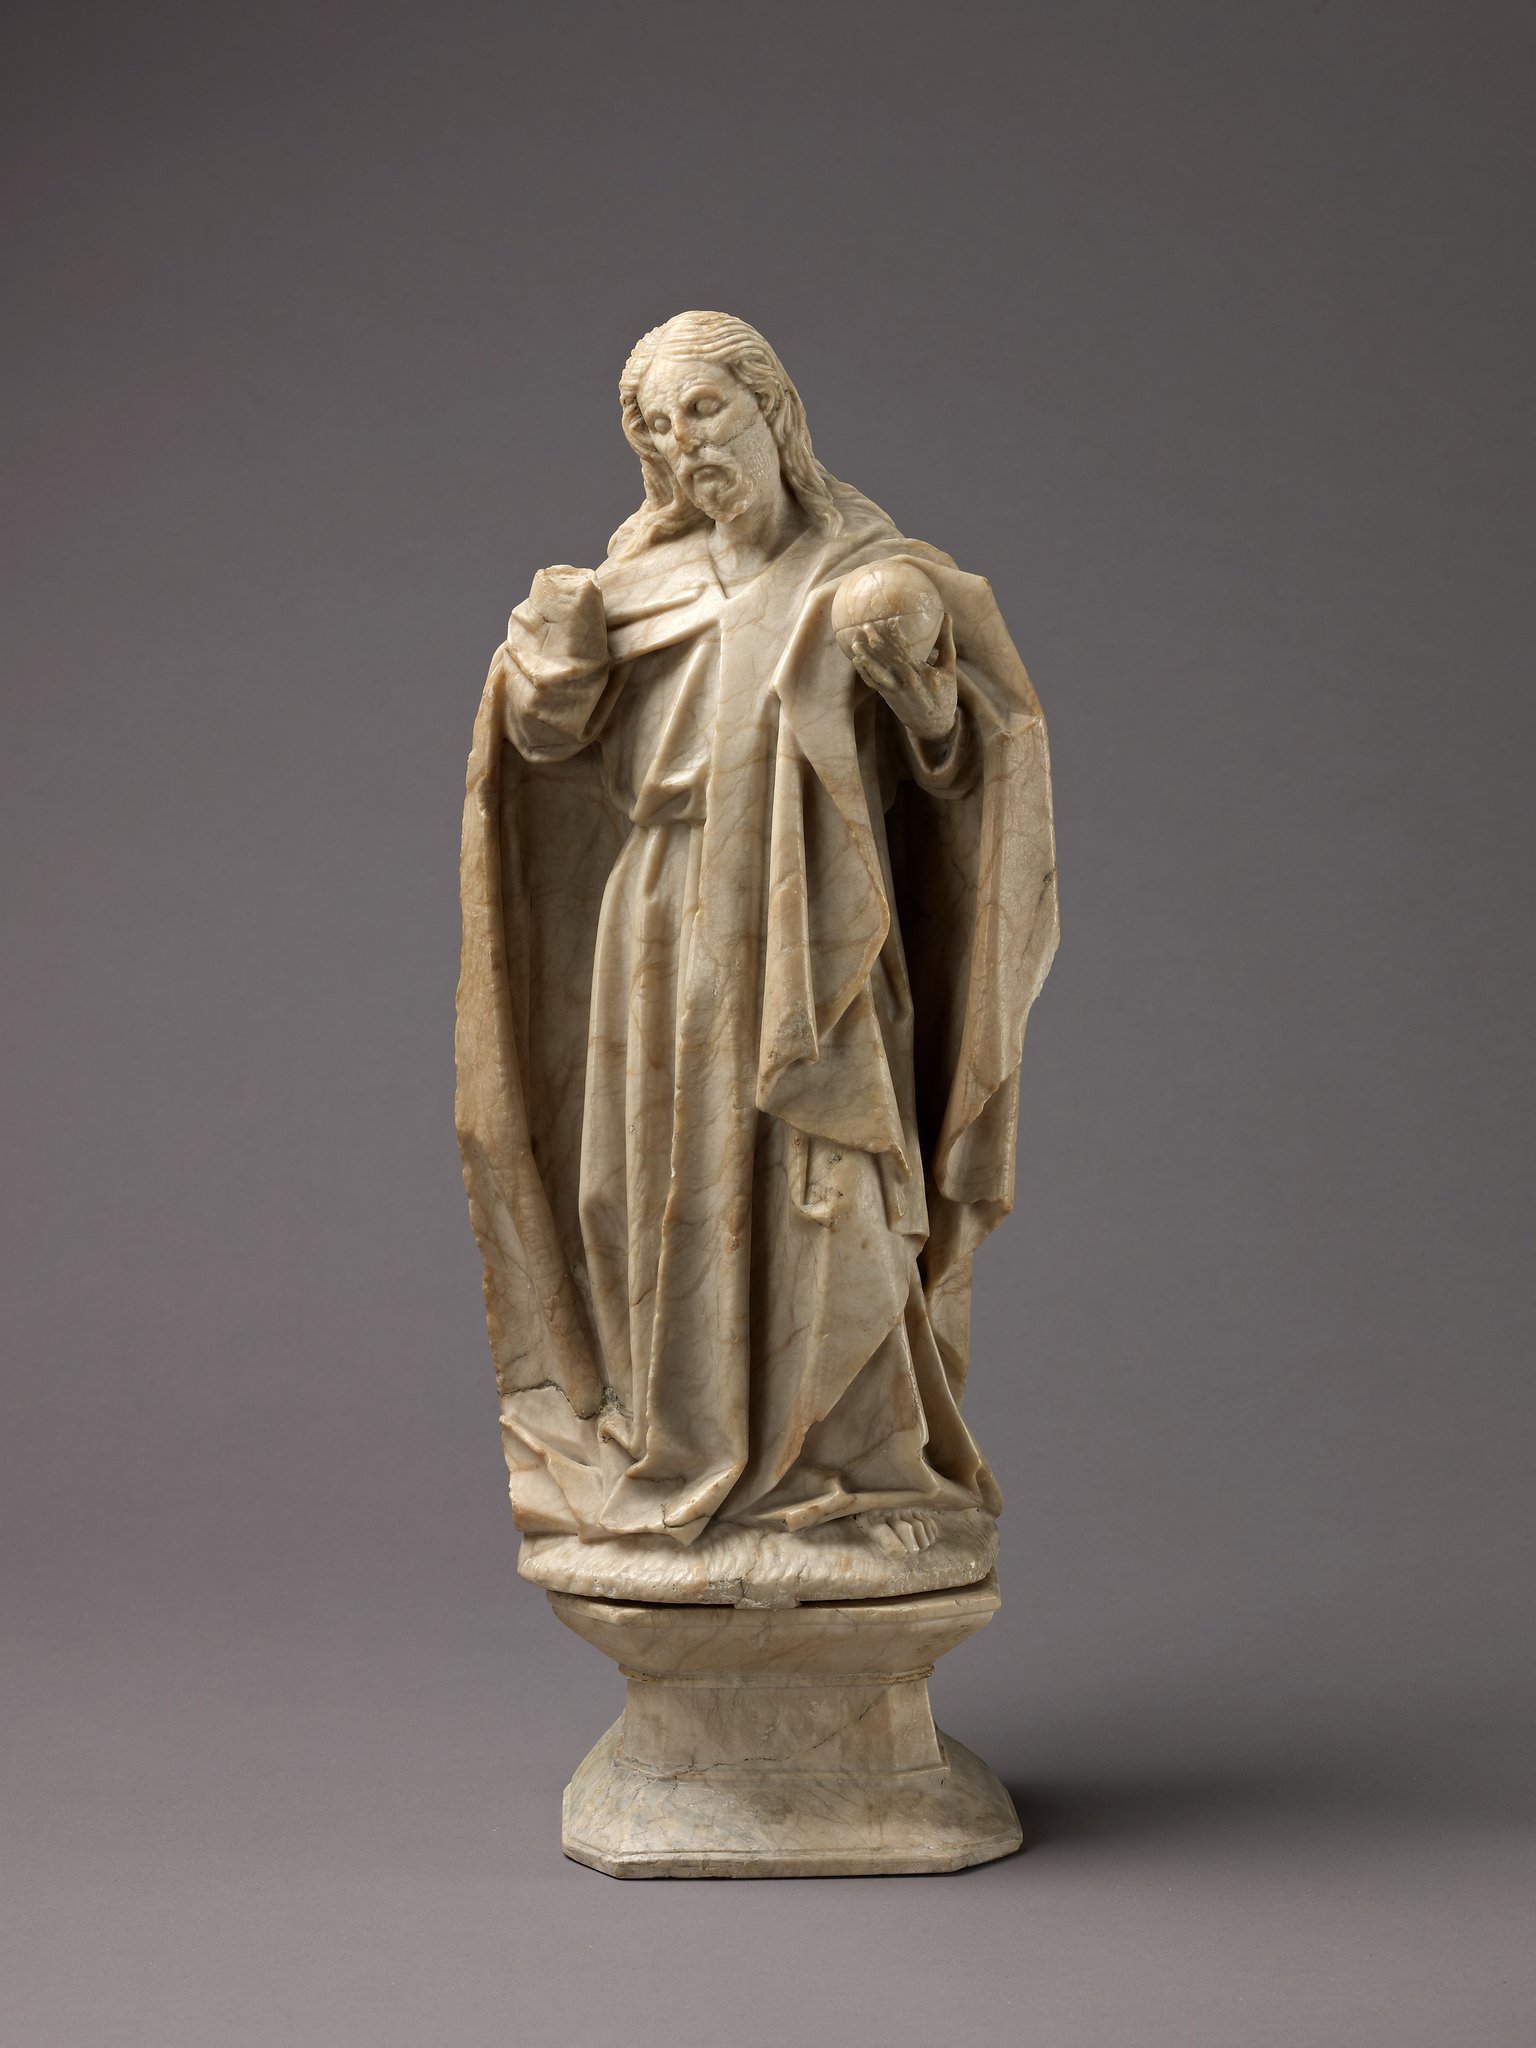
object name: statue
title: Statue: Christ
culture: dutch or french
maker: southern netherlands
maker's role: artist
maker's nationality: southern netherlands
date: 1450-1470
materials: alabaster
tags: christ